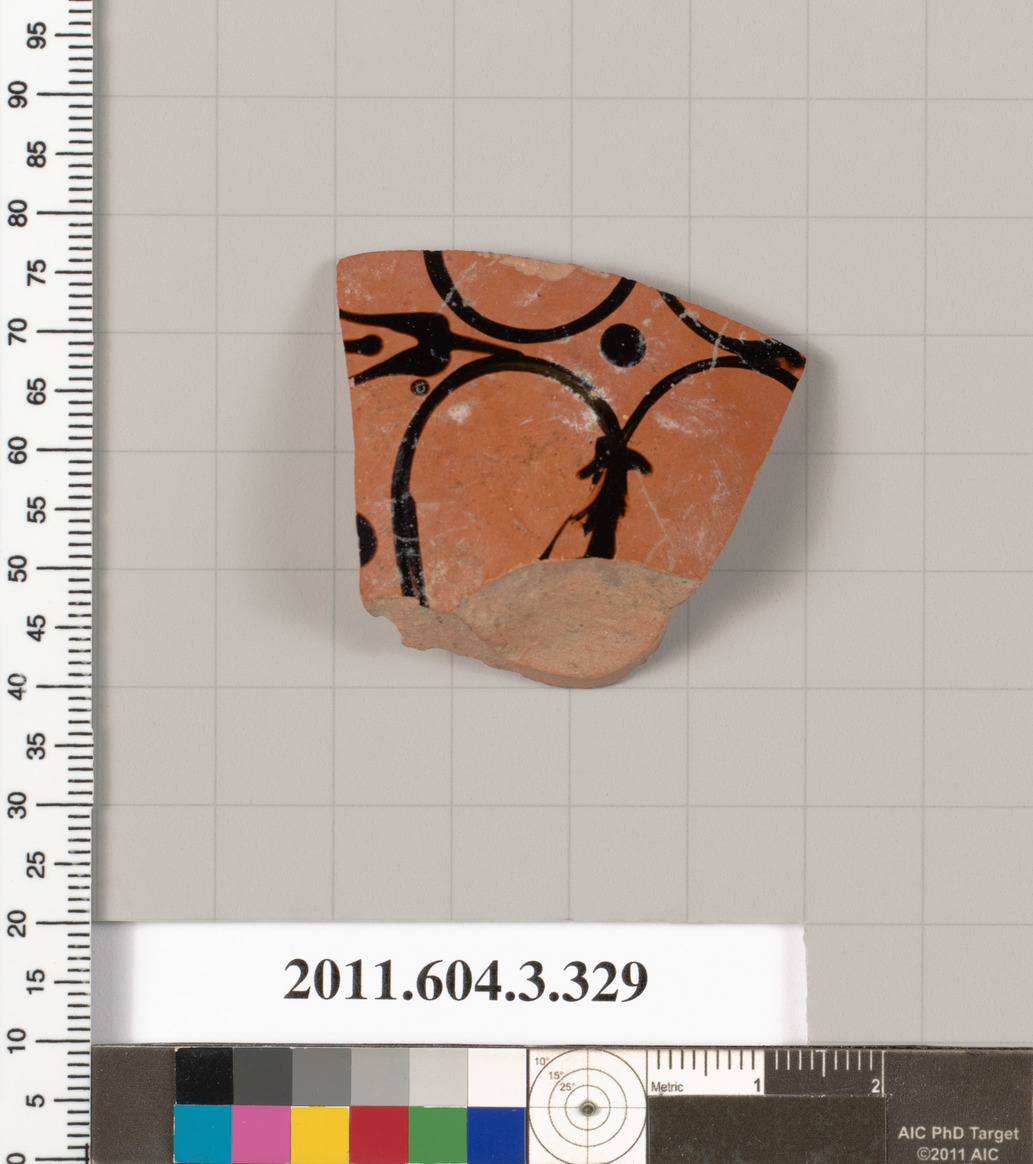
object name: neck amphora fragment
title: Terracotta fragment of a neck-amphora (jar)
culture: greek, attic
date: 540-530 BCE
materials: terracotta